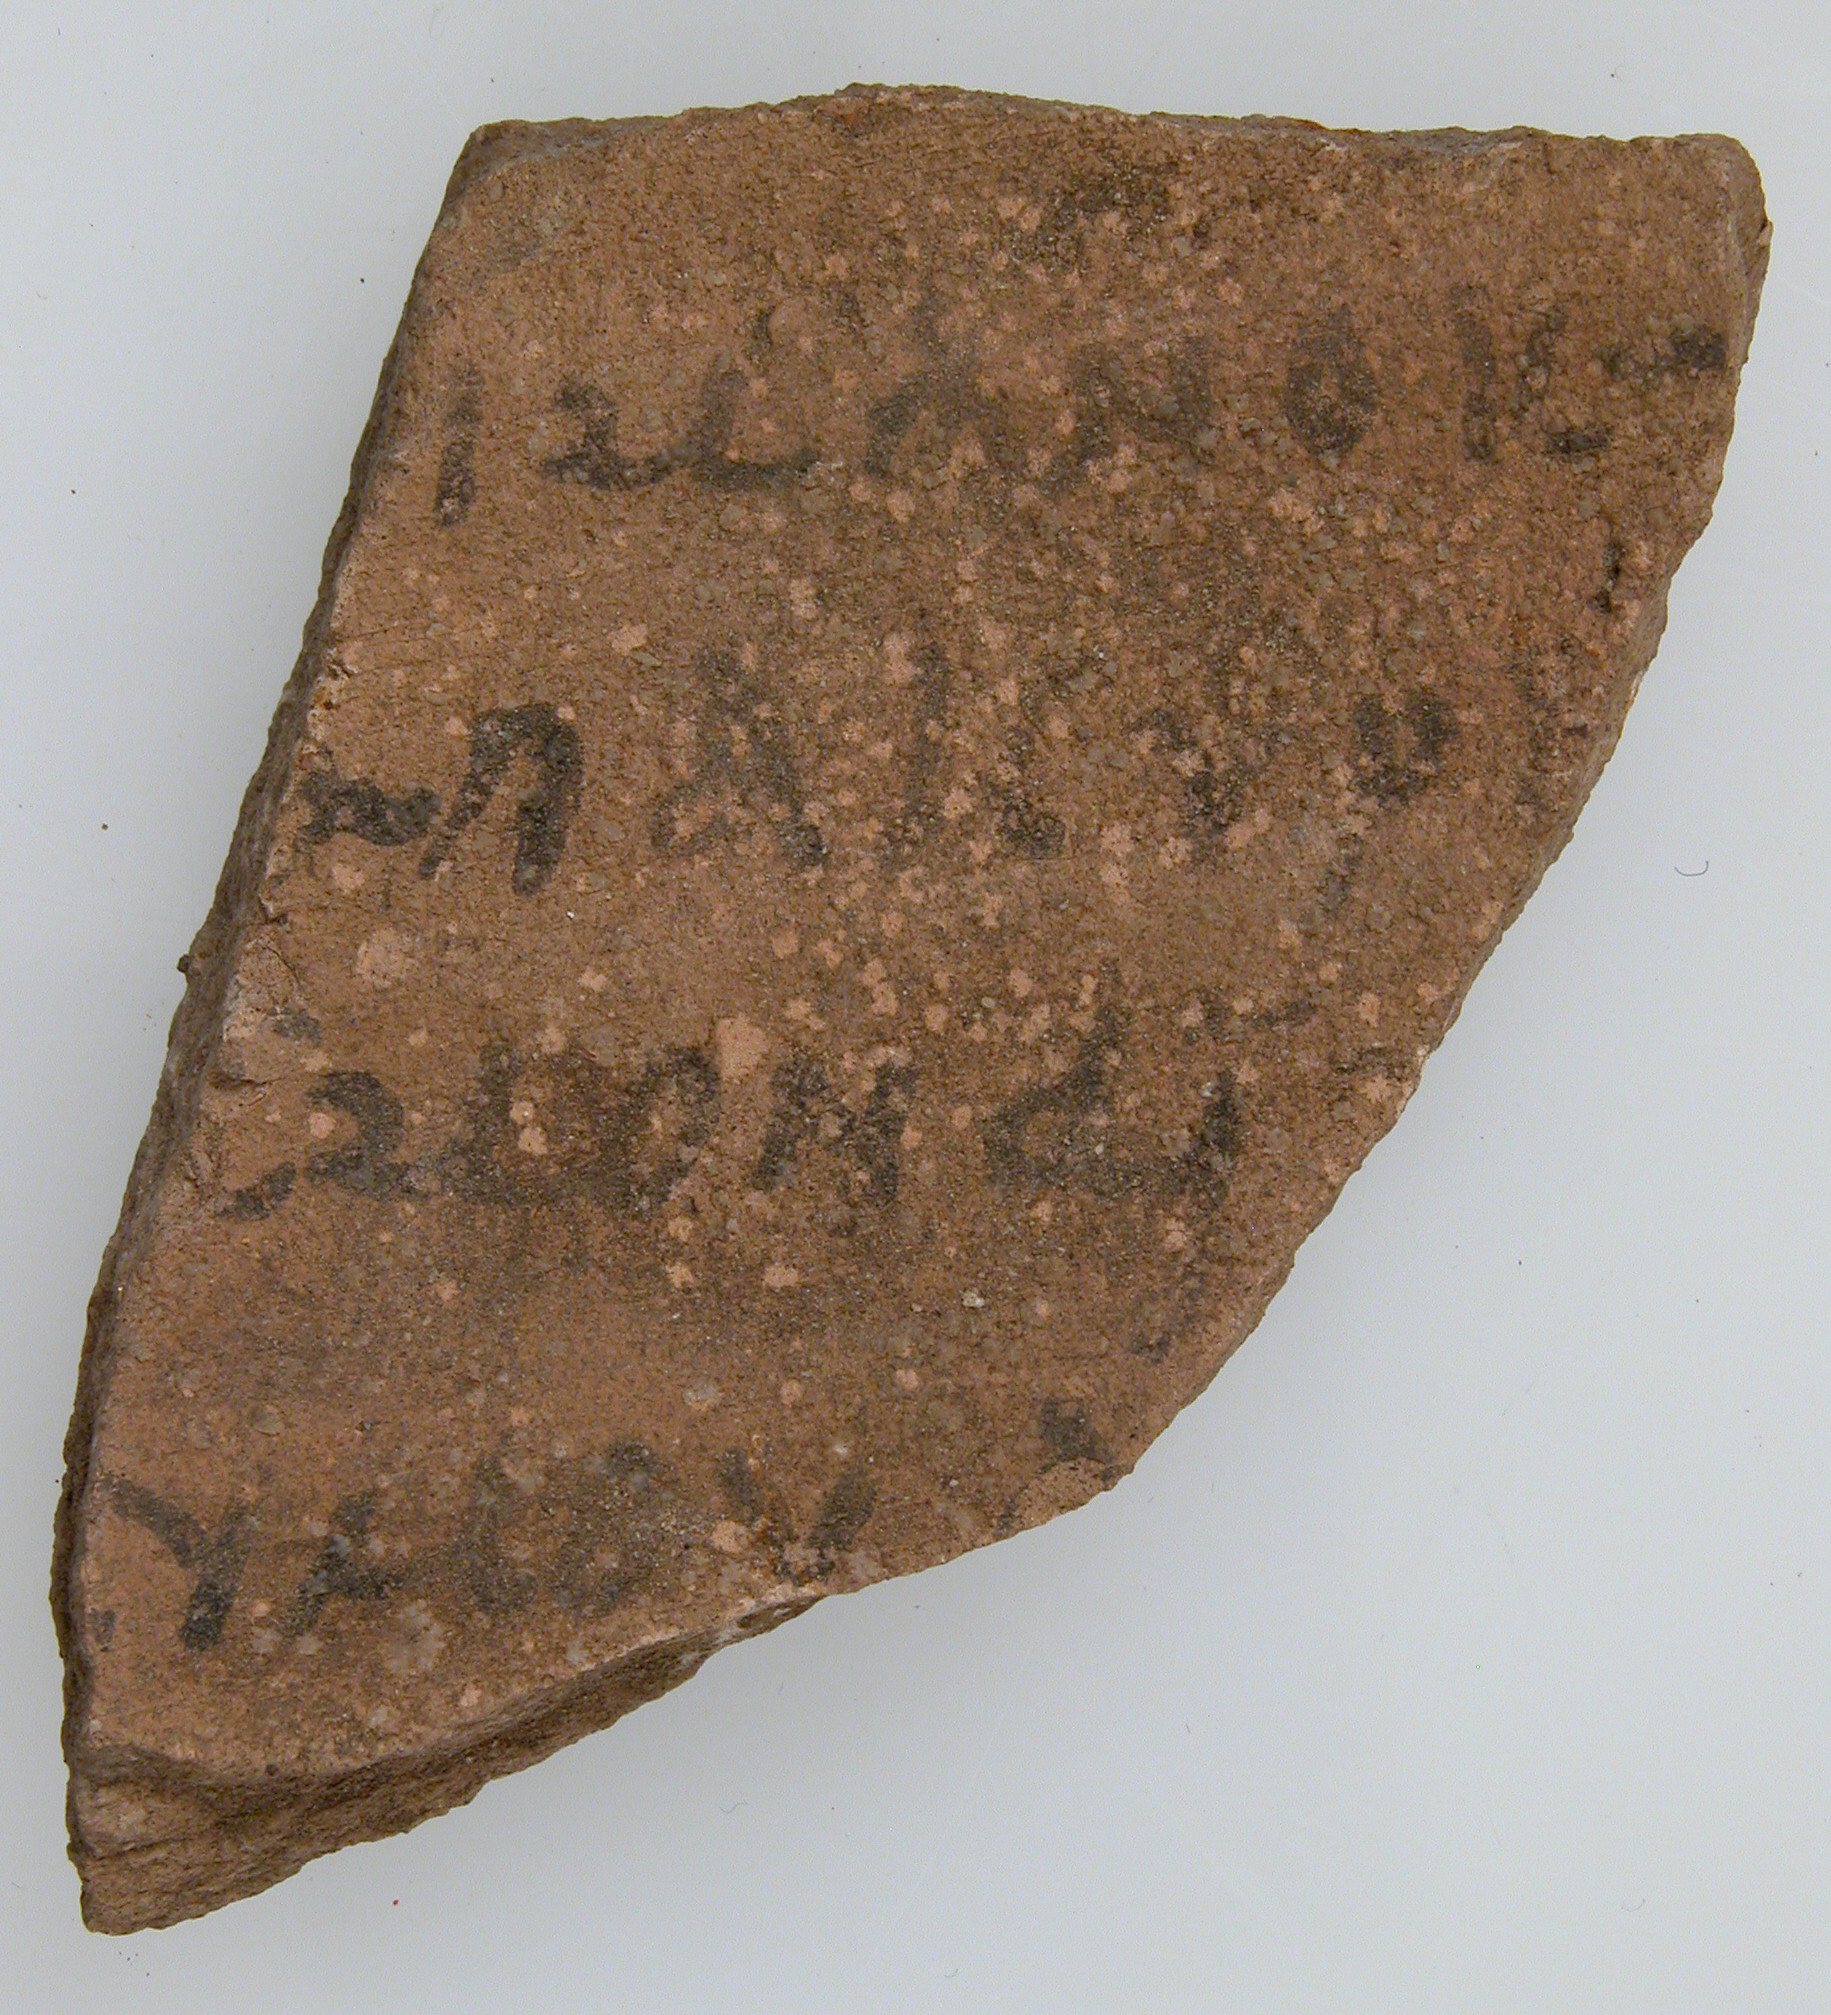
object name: ostrakon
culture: coptic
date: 600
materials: ink, pottery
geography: egypt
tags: coptic,documents